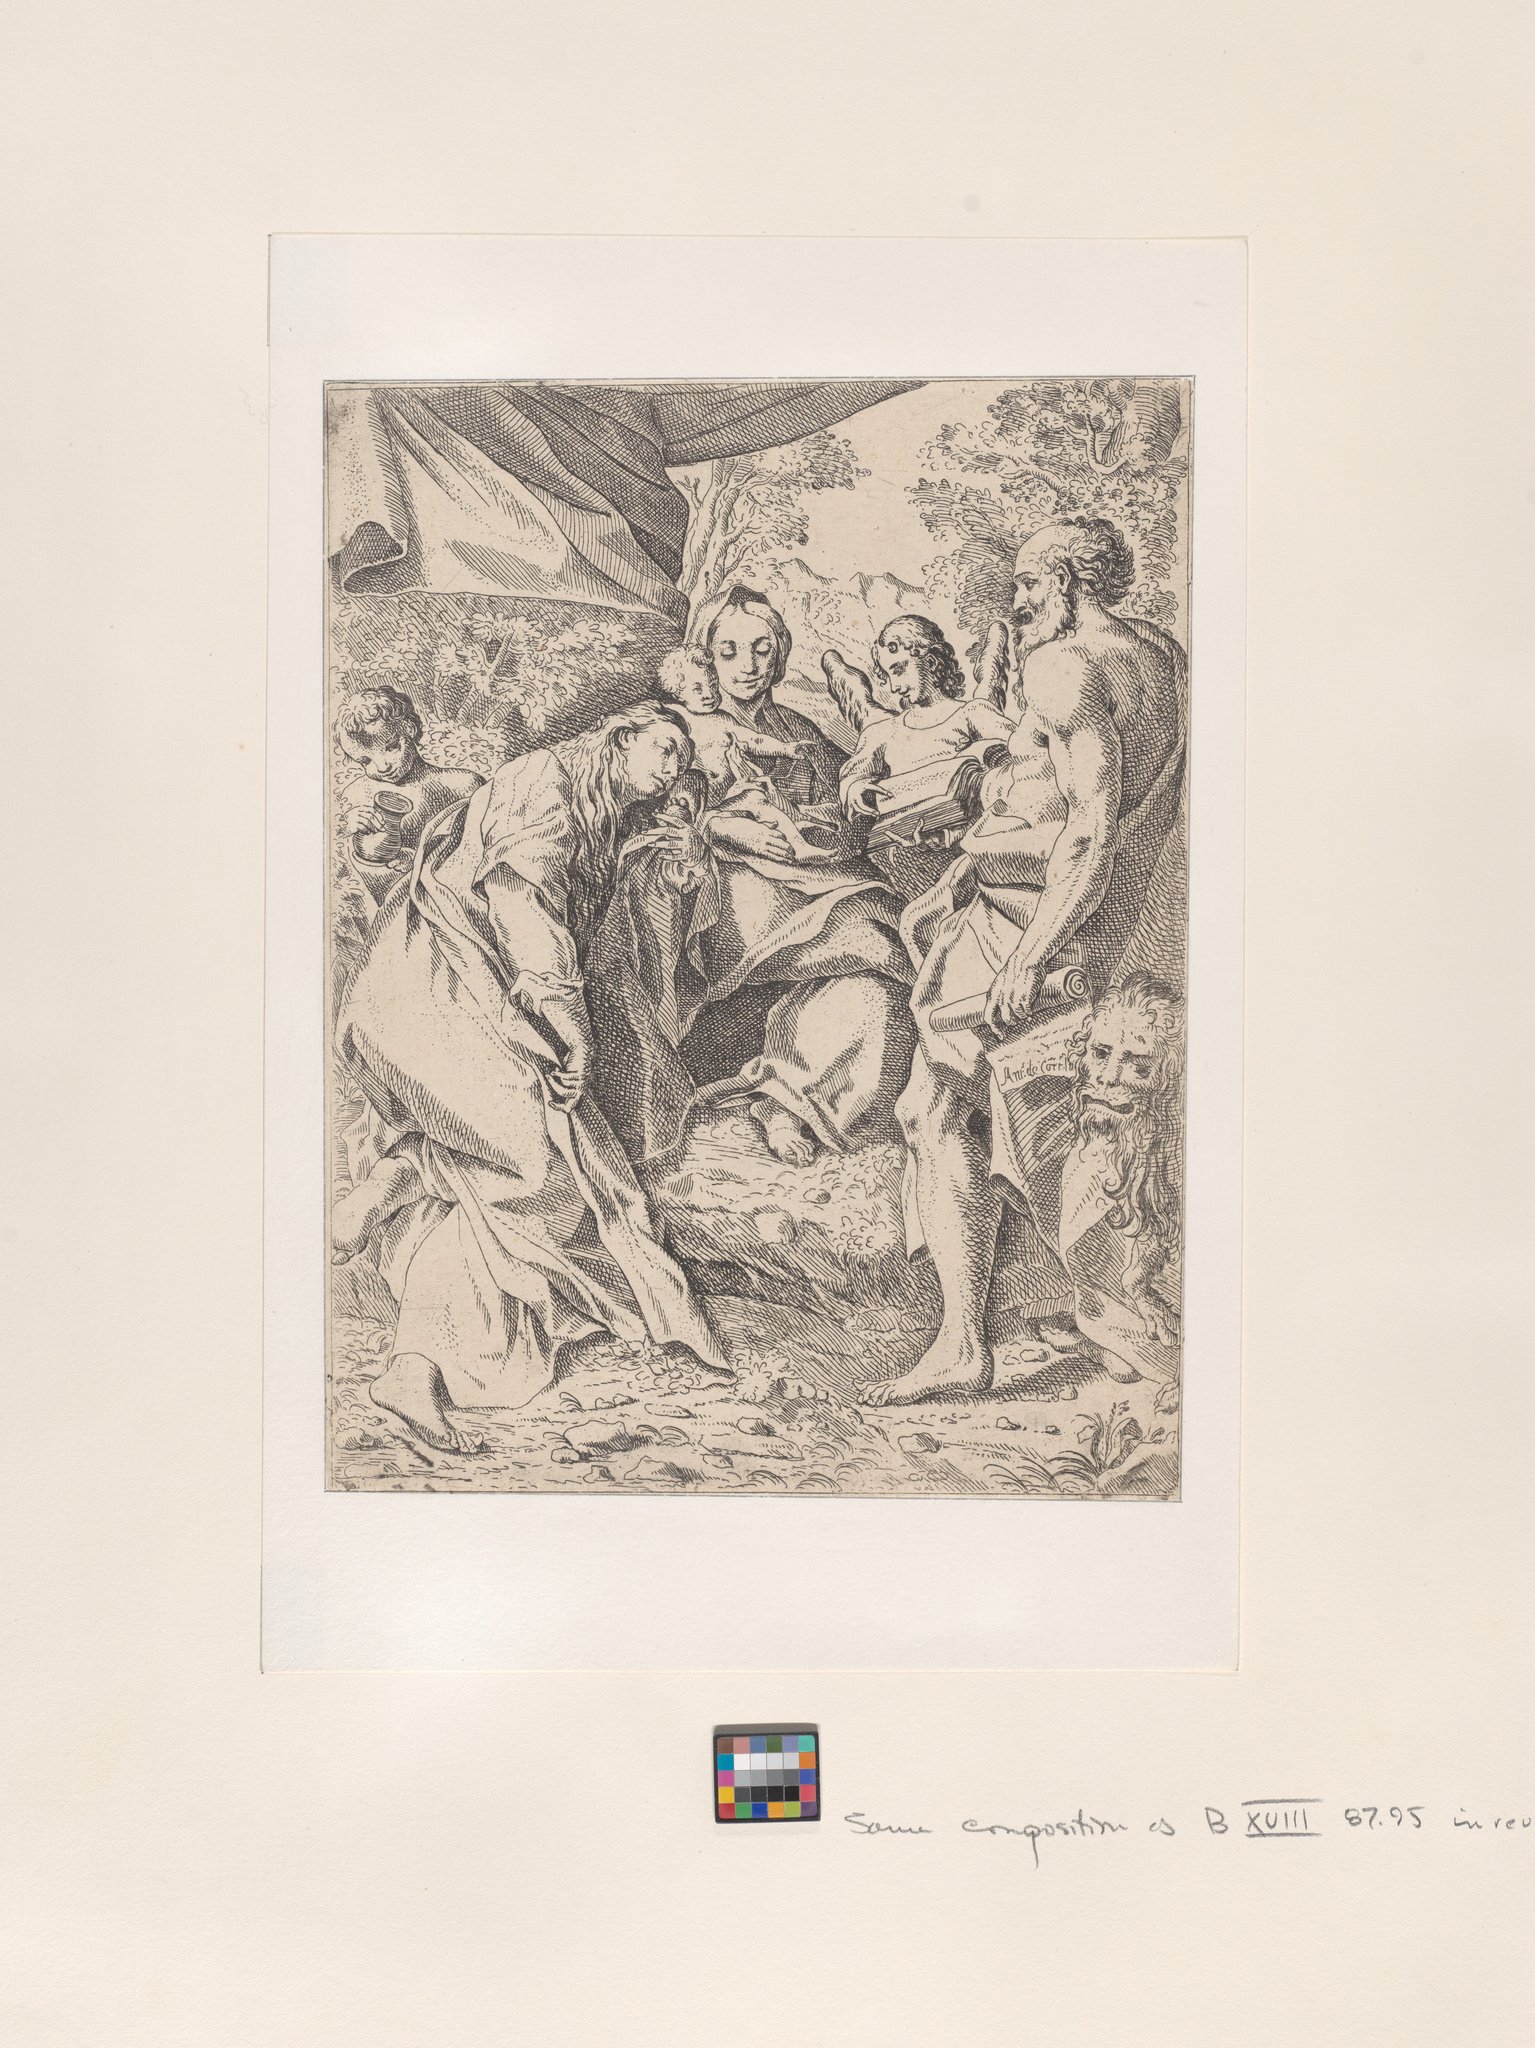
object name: print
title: Virgin and Child, with Saints Jerome and Mary Magdalene and angels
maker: Anonymous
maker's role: artist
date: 1601-1700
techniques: etching